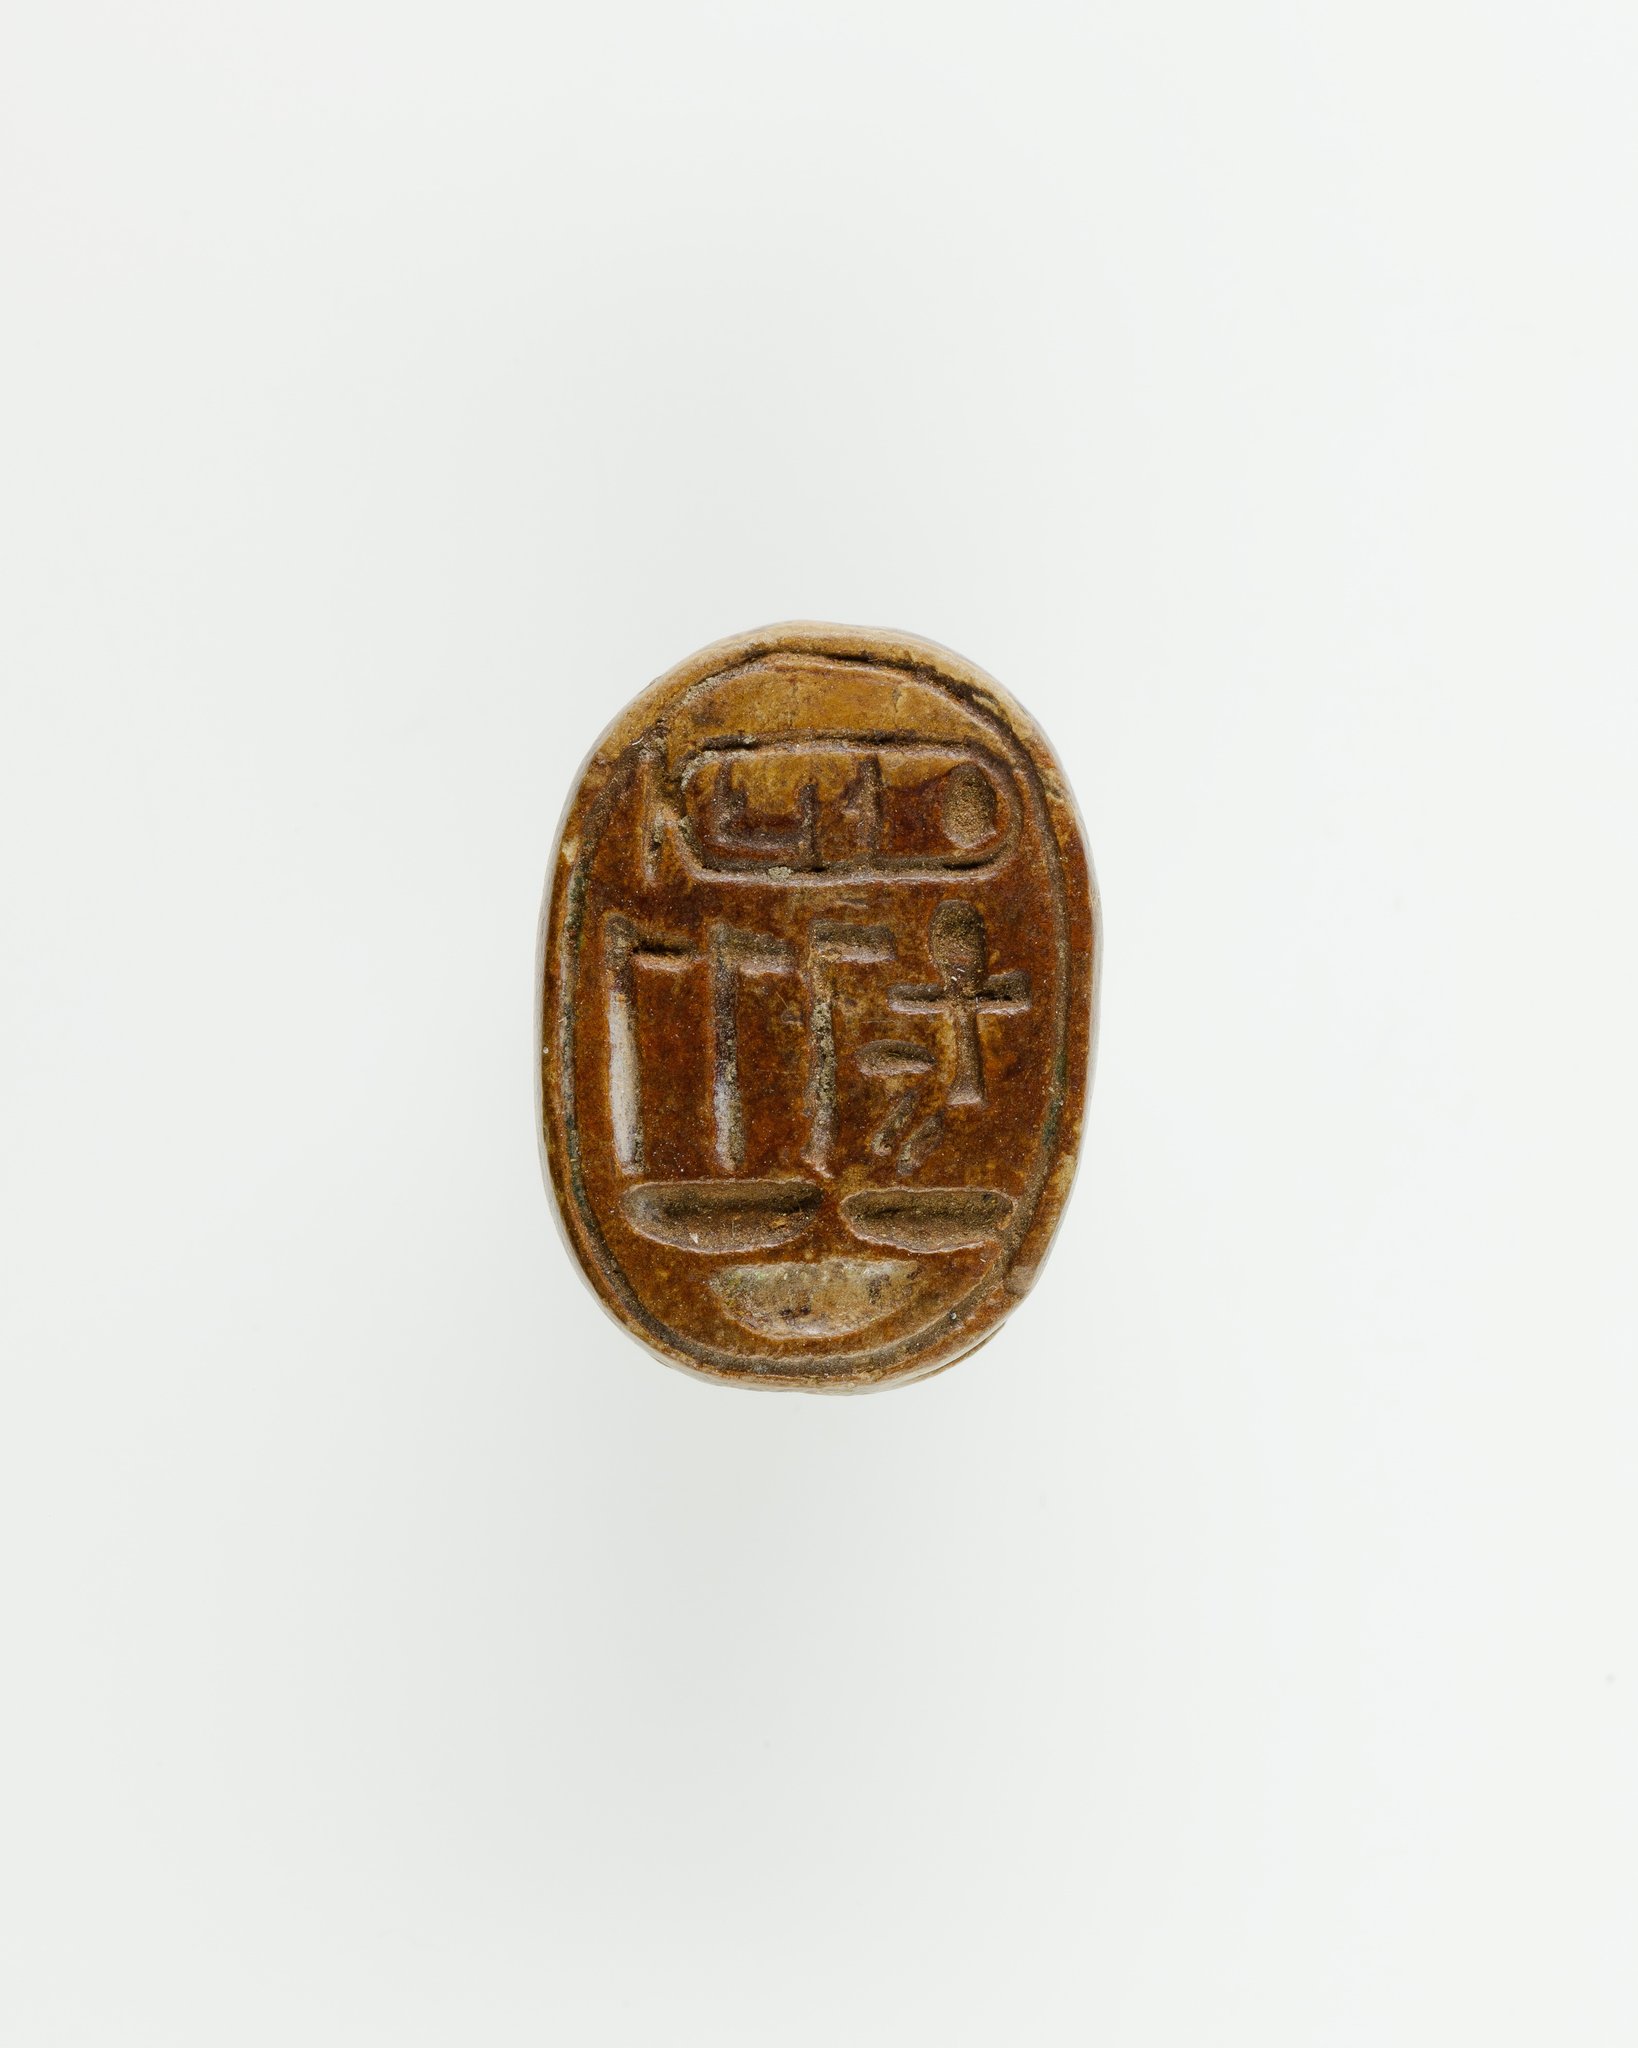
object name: scarab, maatkare hatshepsut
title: Scarab Inscribed With the Cartouche of Maatkare (Hatshepsut)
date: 1479-1458 BCE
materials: stone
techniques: glazing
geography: egypt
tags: scarabs